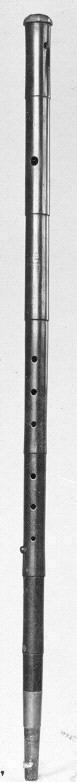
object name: walking stick flageolet in a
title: Walking-Stick Flageolet in A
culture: american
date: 1801-1833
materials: bone, brass, ivory, wood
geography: united states